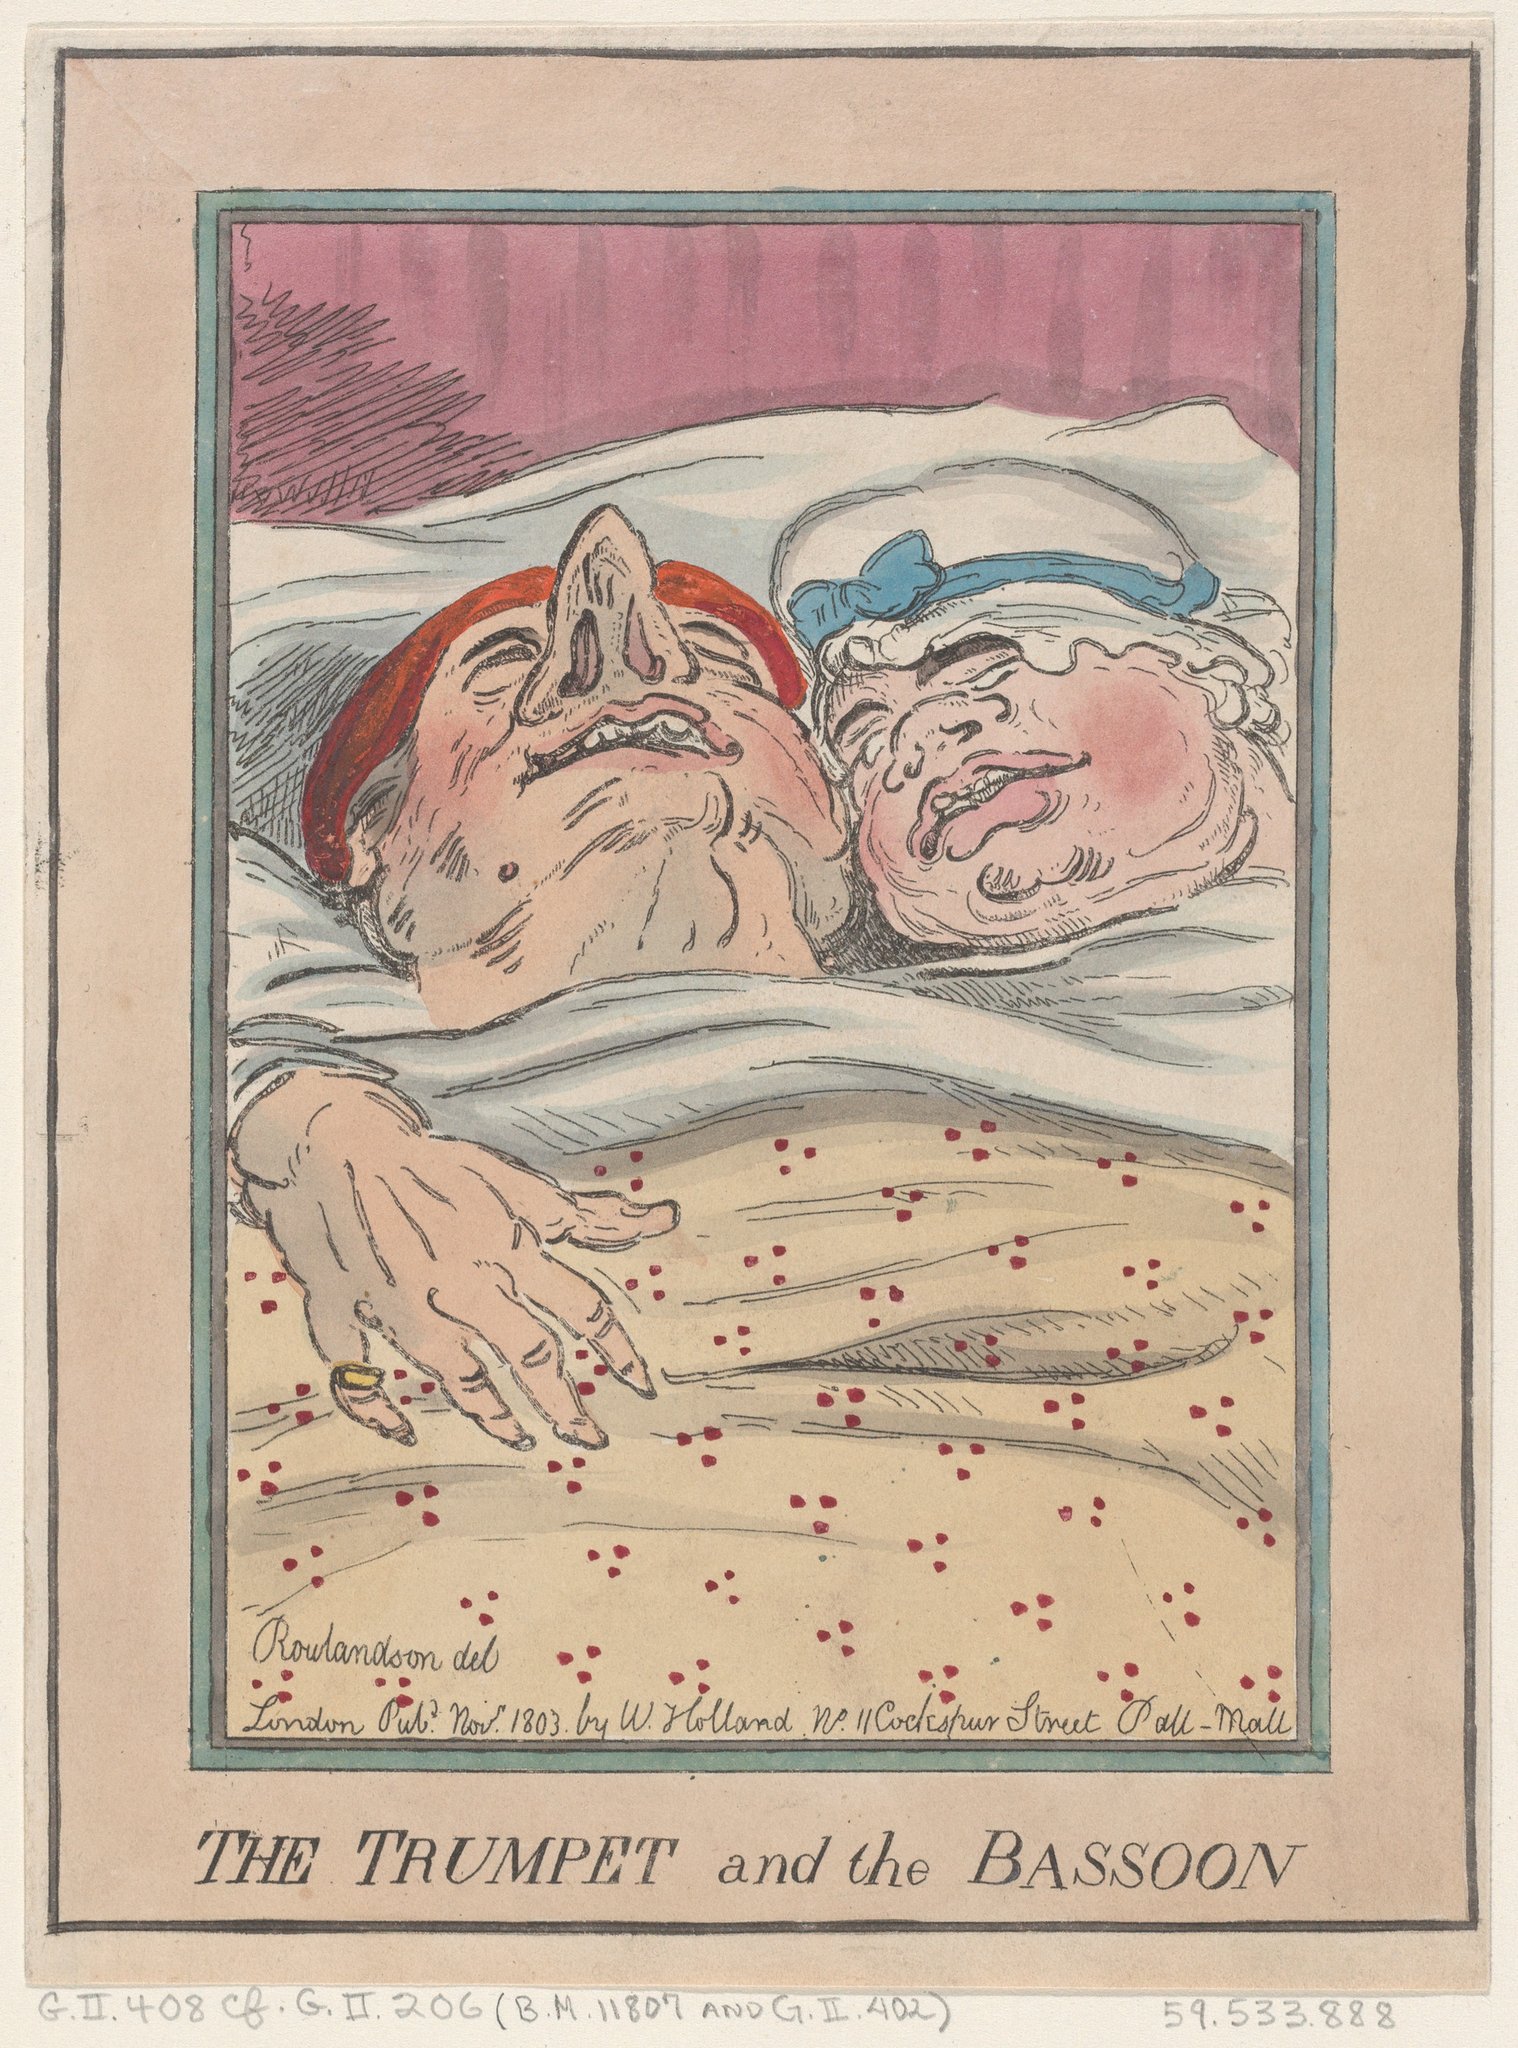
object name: print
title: The Trumpet and the Bassoon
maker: thomas rowlandson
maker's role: artist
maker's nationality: british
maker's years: 1757-1827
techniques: etching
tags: satire,sleeping,men,women